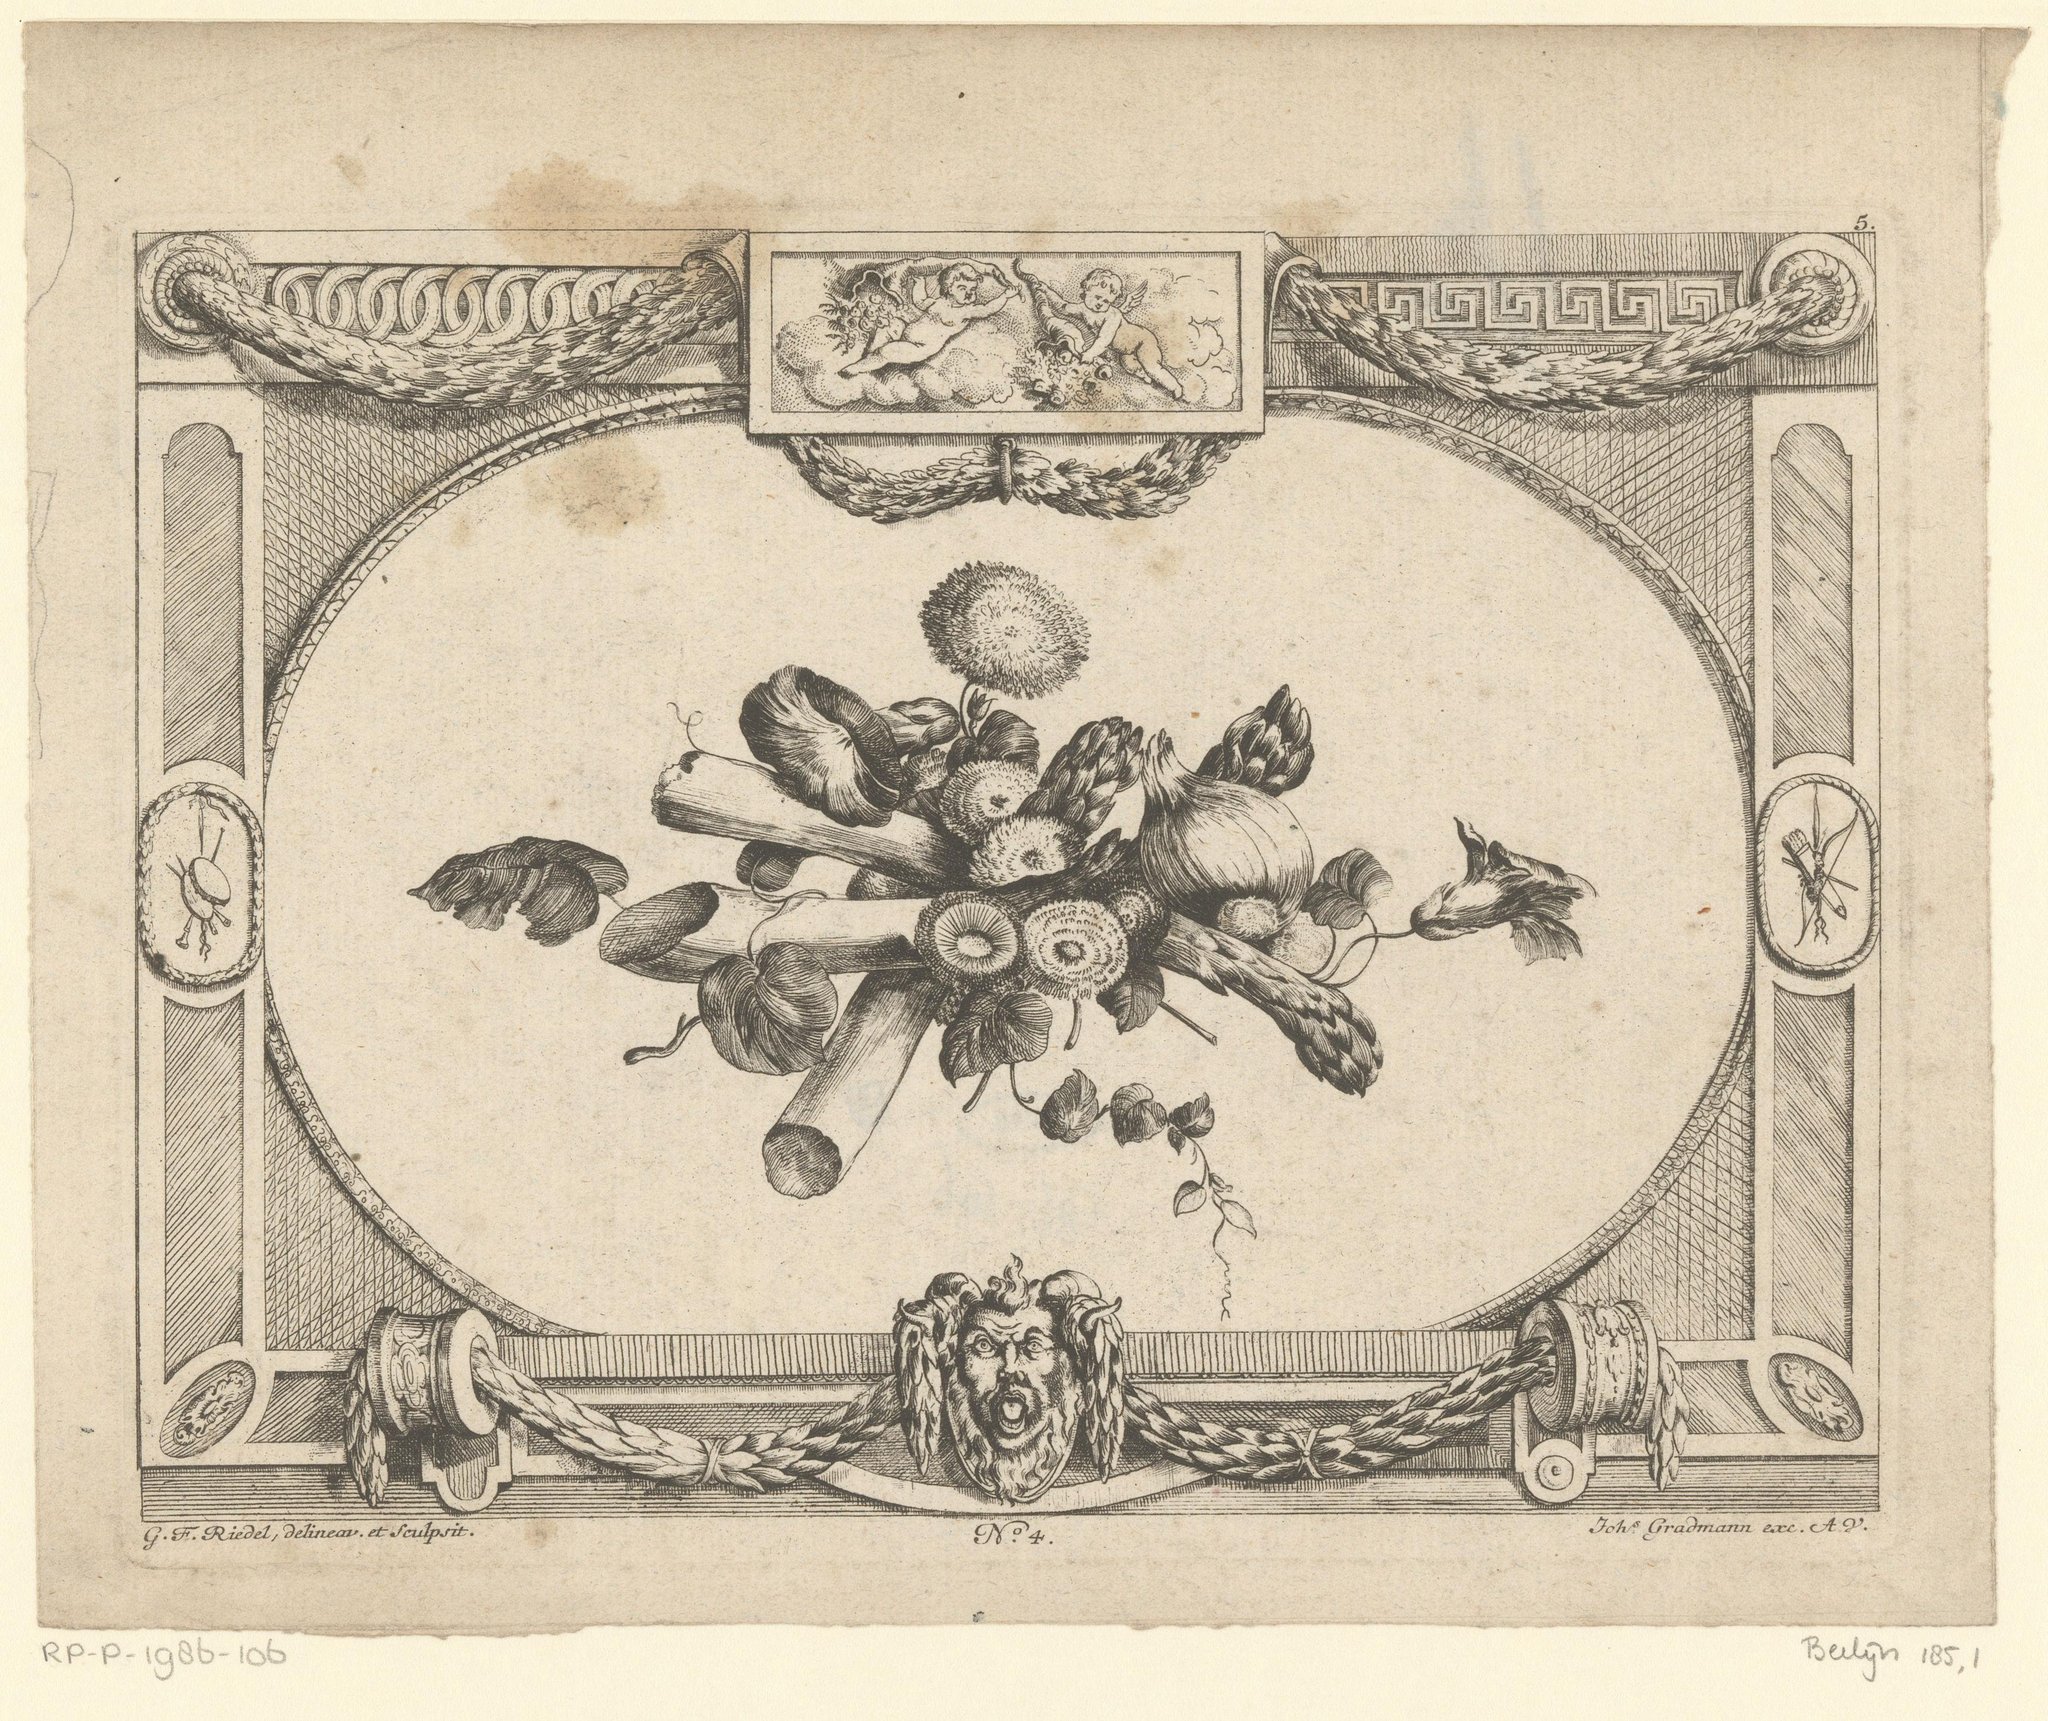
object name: print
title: Omlijsting met saterkop en groenten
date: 1778-1779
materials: paper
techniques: etching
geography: augsburg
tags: fruits and vegetables ~ ornament, ornaments ~ art (+ framing decorations), satyr(s) (in general)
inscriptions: collector's mark: Lugt 2228, collector's mark: Lugt 2760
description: Een ornamentele omlijsting met guirlandes, een saterkop, twee medaillons met pijl en boog en muziekinstrumenten en een afbeelding van twee putti met hoornen des overvloeds. In het midden bloemen en groenten. Uitgeversnummer 4.